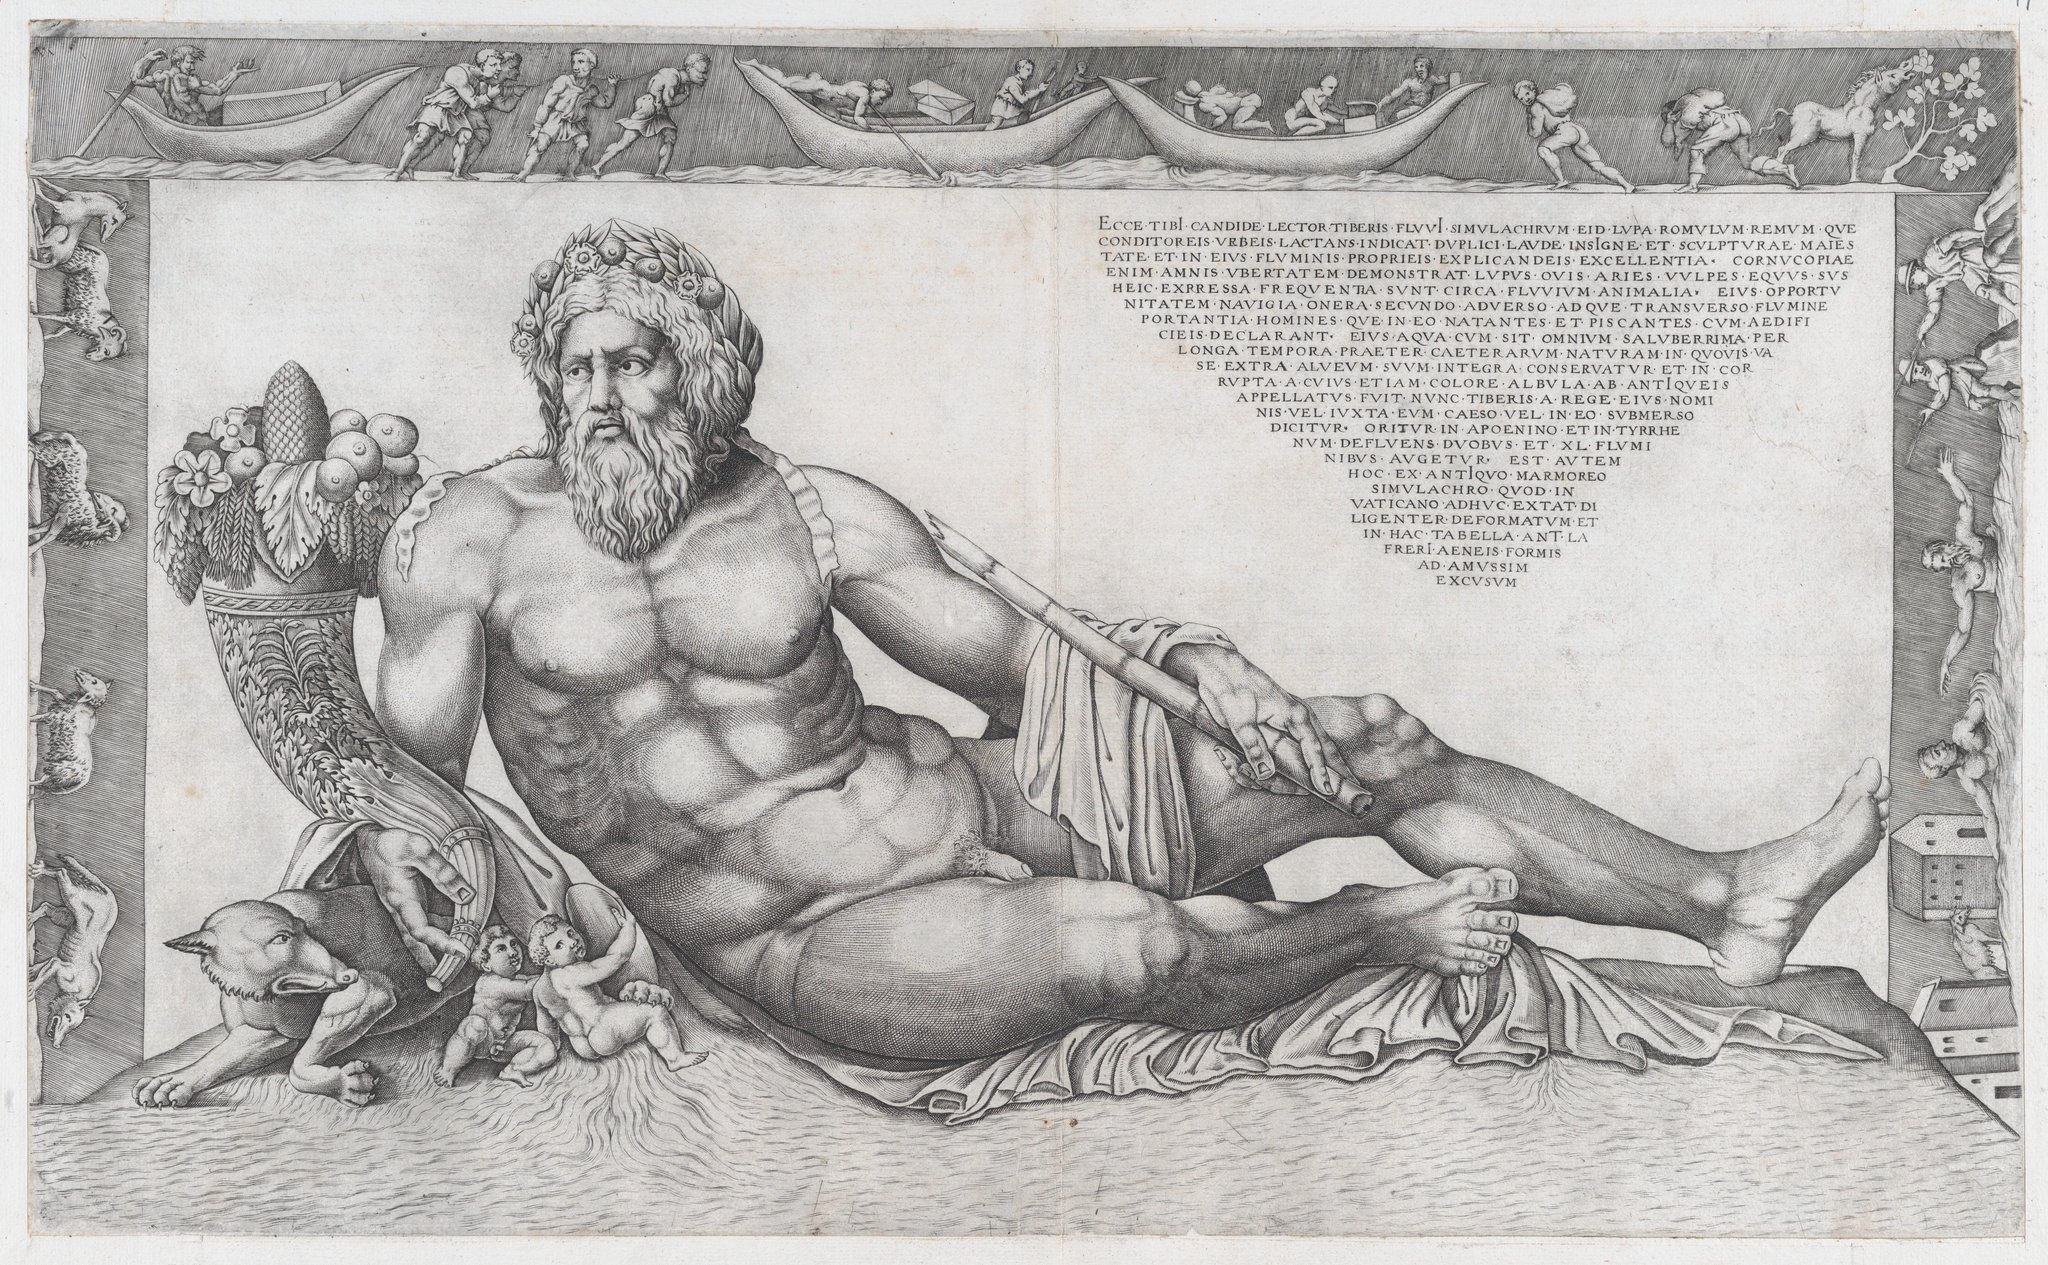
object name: print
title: The Tiber, from "Speculum Romanae Magnificentiae"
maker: nicolas beatrizet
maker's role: artist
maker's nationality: french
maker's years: 1515-1566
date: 1534-1566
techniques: engraving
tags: animals,fruit,infants,male nudes,cows,dogs,horses,sheep,boats